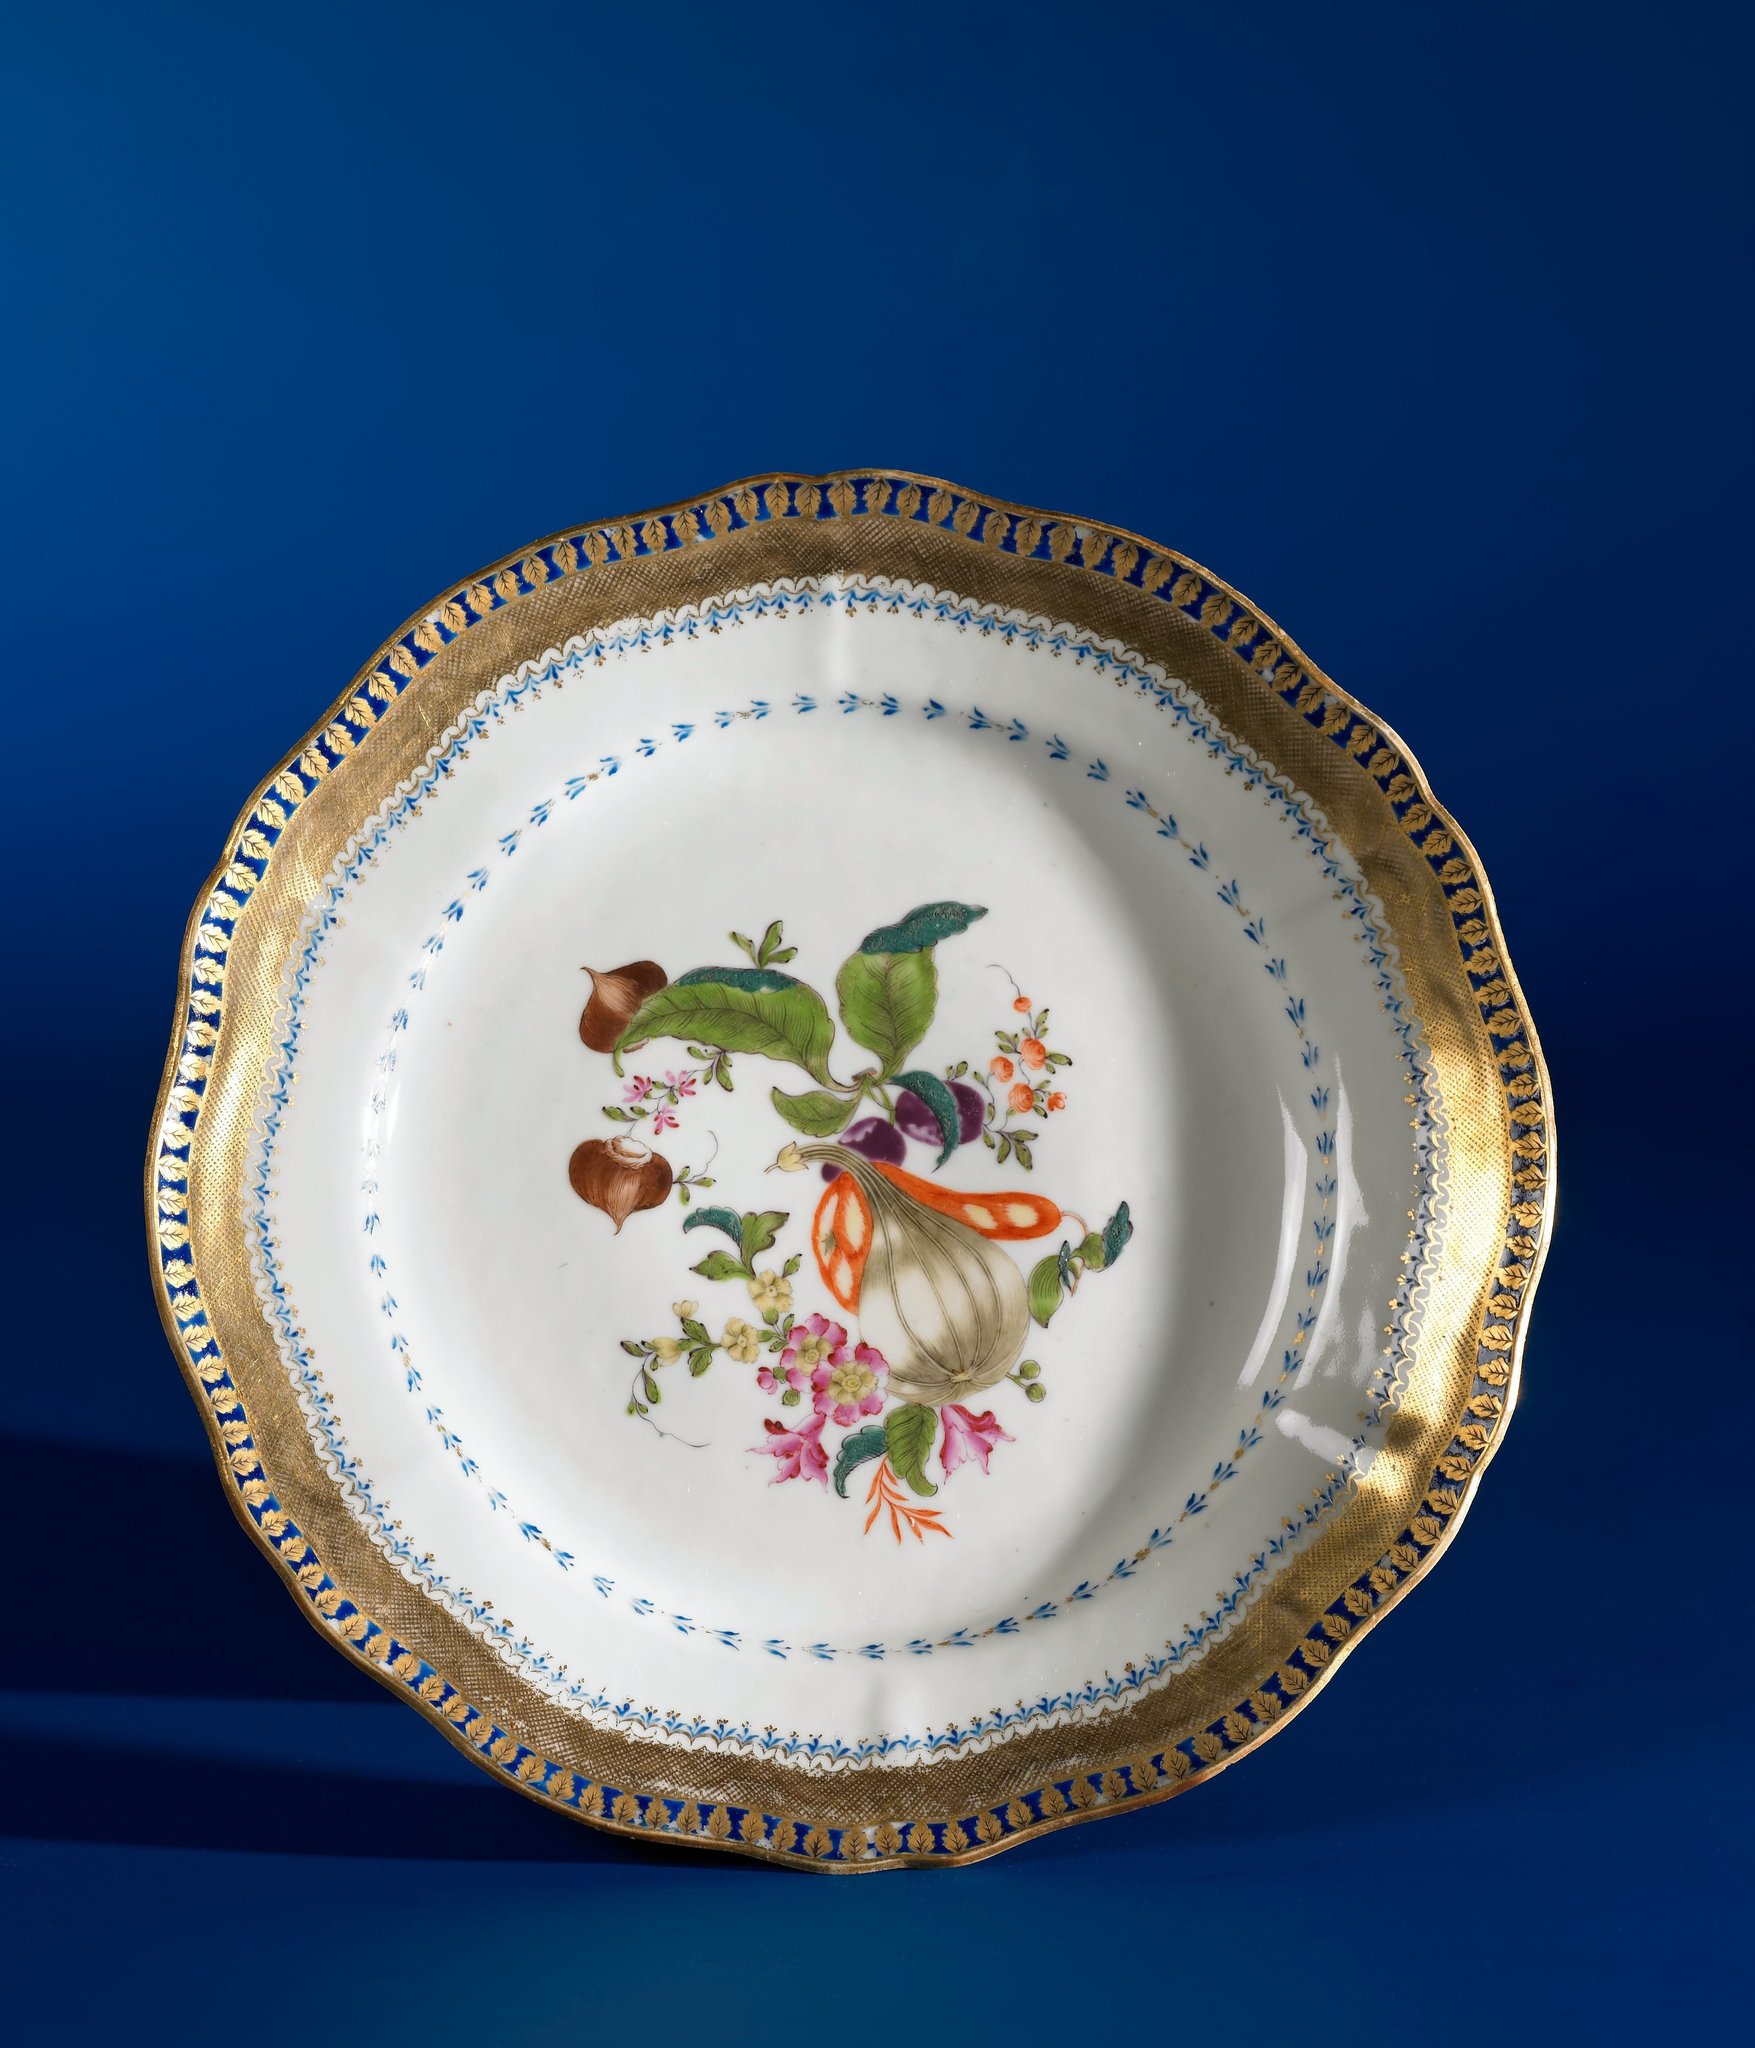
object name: plate dish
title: Lobed plate with fruit and flower sprays and ornamental borders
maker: Anonymous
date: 1775-1799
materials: glaze, gold, paint, porcelain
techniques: firing, gilding, turning, vitrification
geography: china